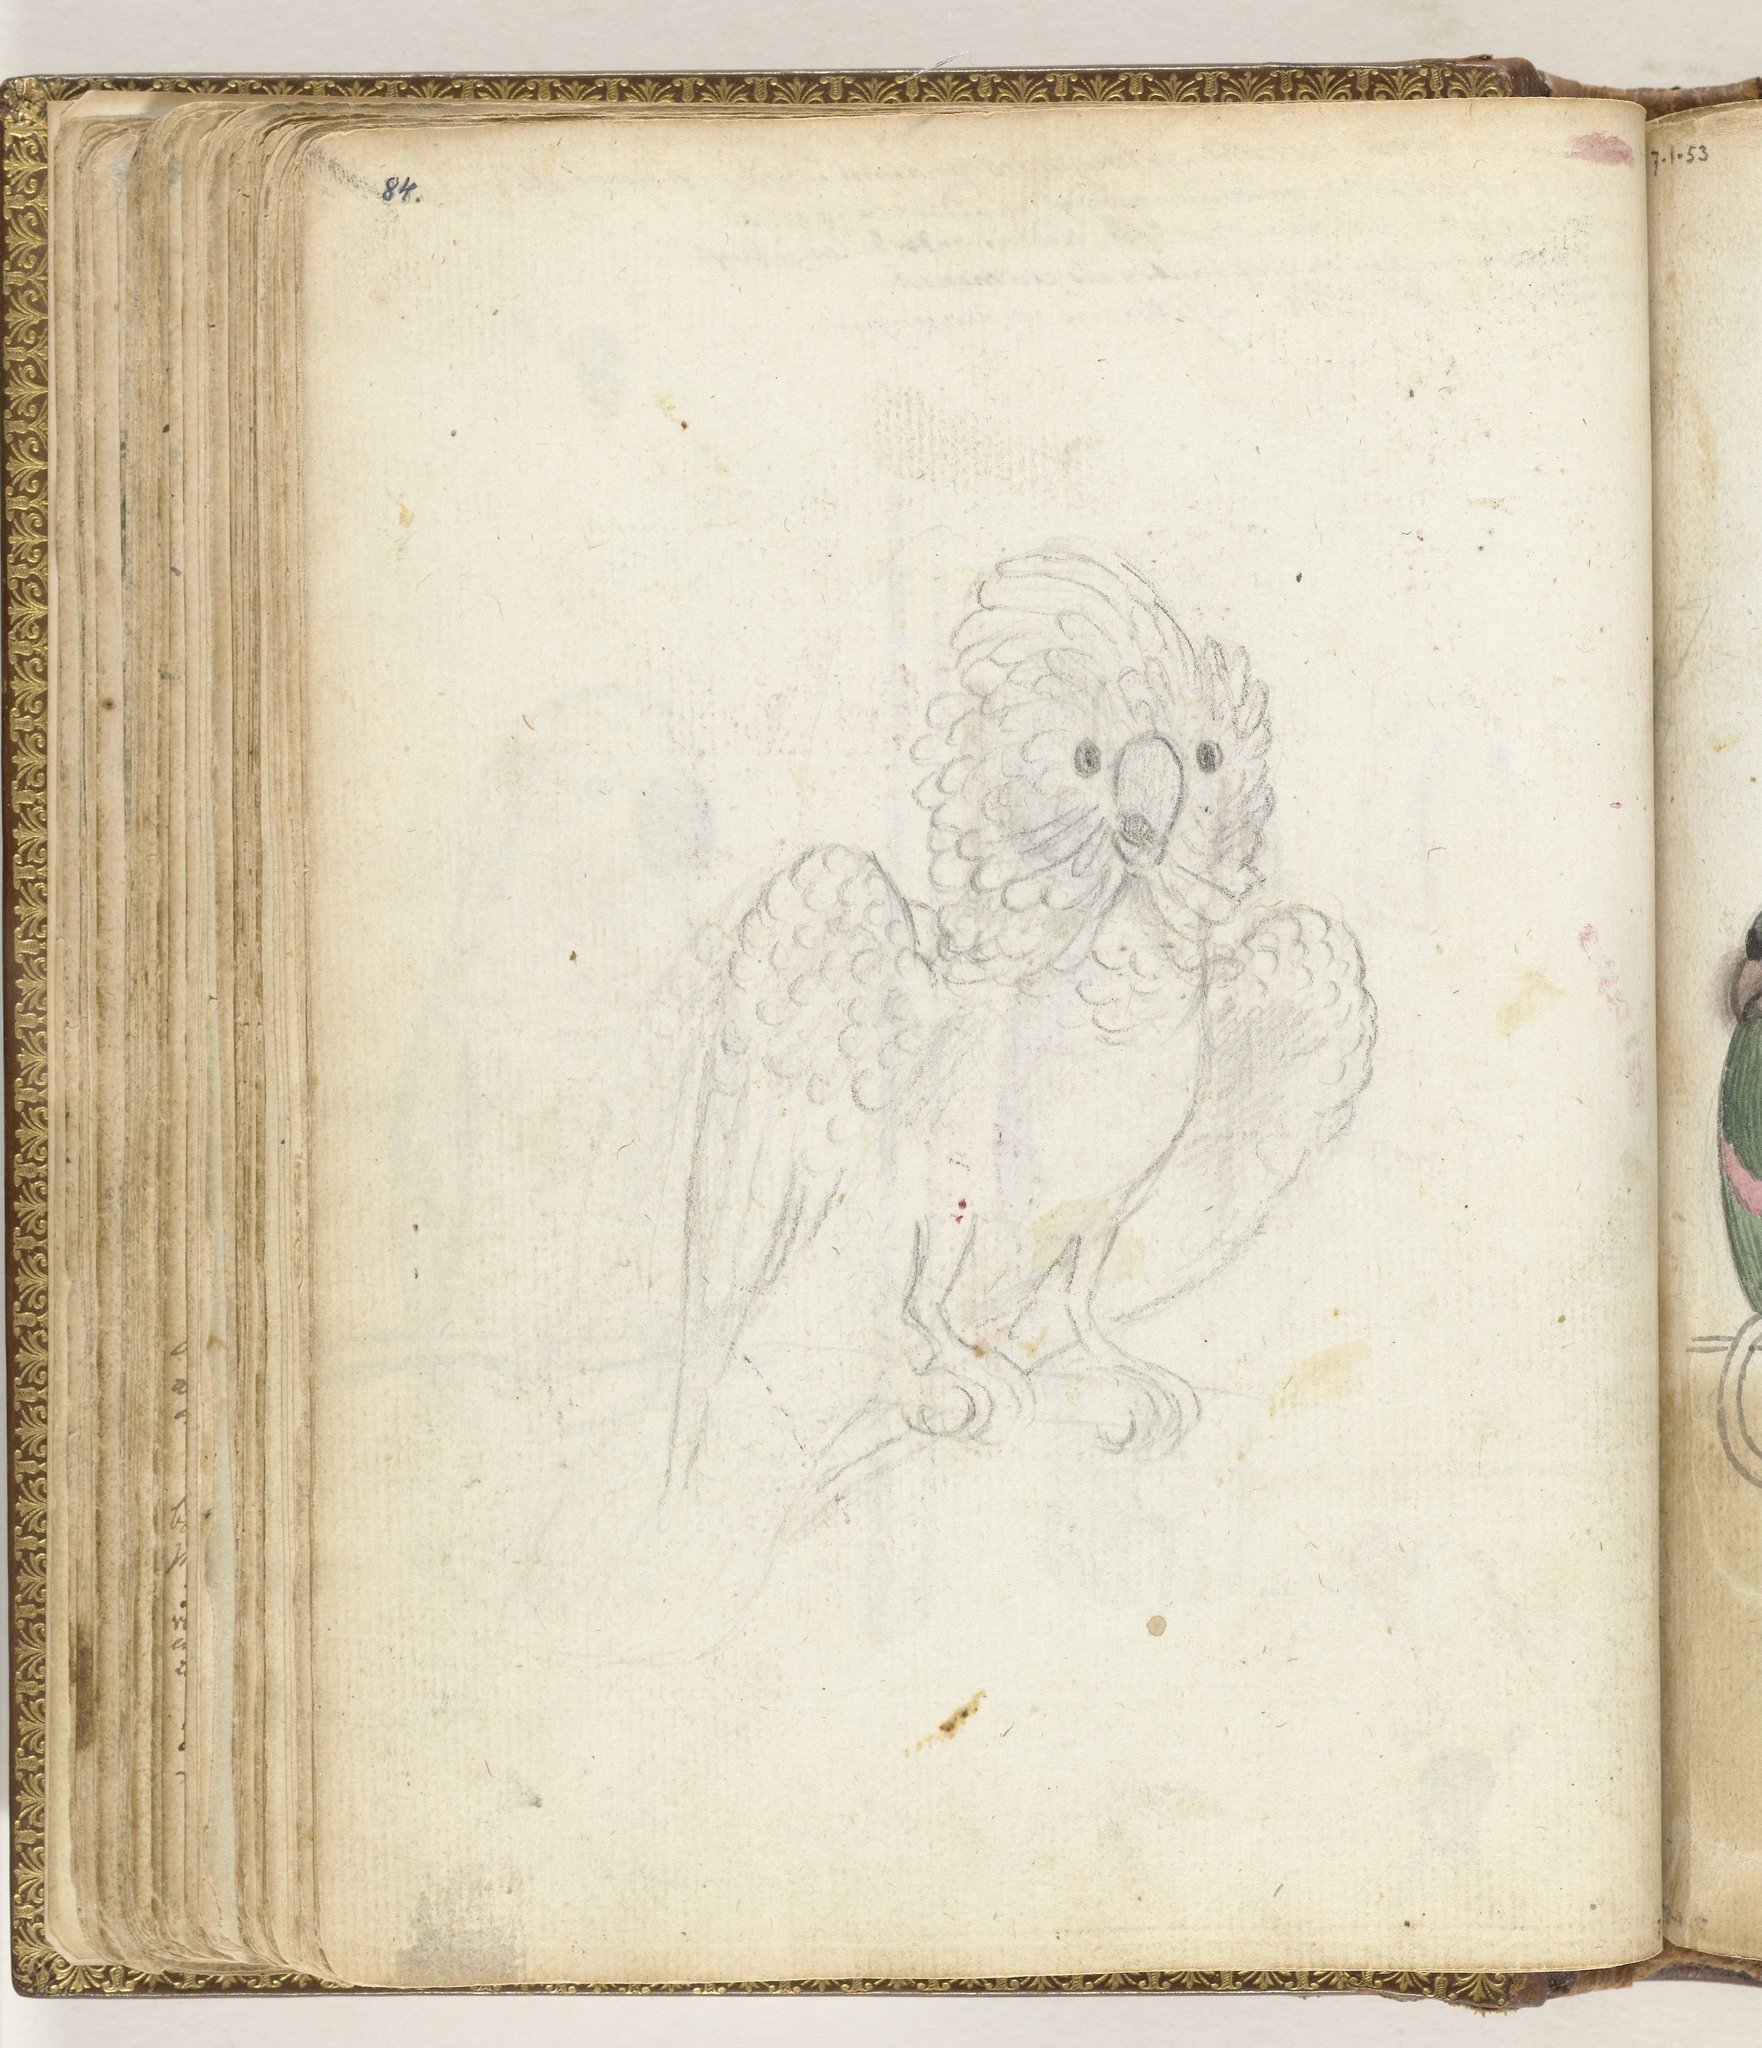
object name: drawing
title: Ambonse kaketoe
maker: jan brandes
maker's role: draughtsman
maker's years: 1743-1808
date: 1784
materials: paper, pencil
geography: jakarta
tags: ornamental birds: cockatoo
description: Potloodschets van de kaketoe uit Indië die Brandes in Zweden als huisdier hield. Onderdeel uit het schetsboek van Jan Brandes, dl. 1 (1808), p. 84.